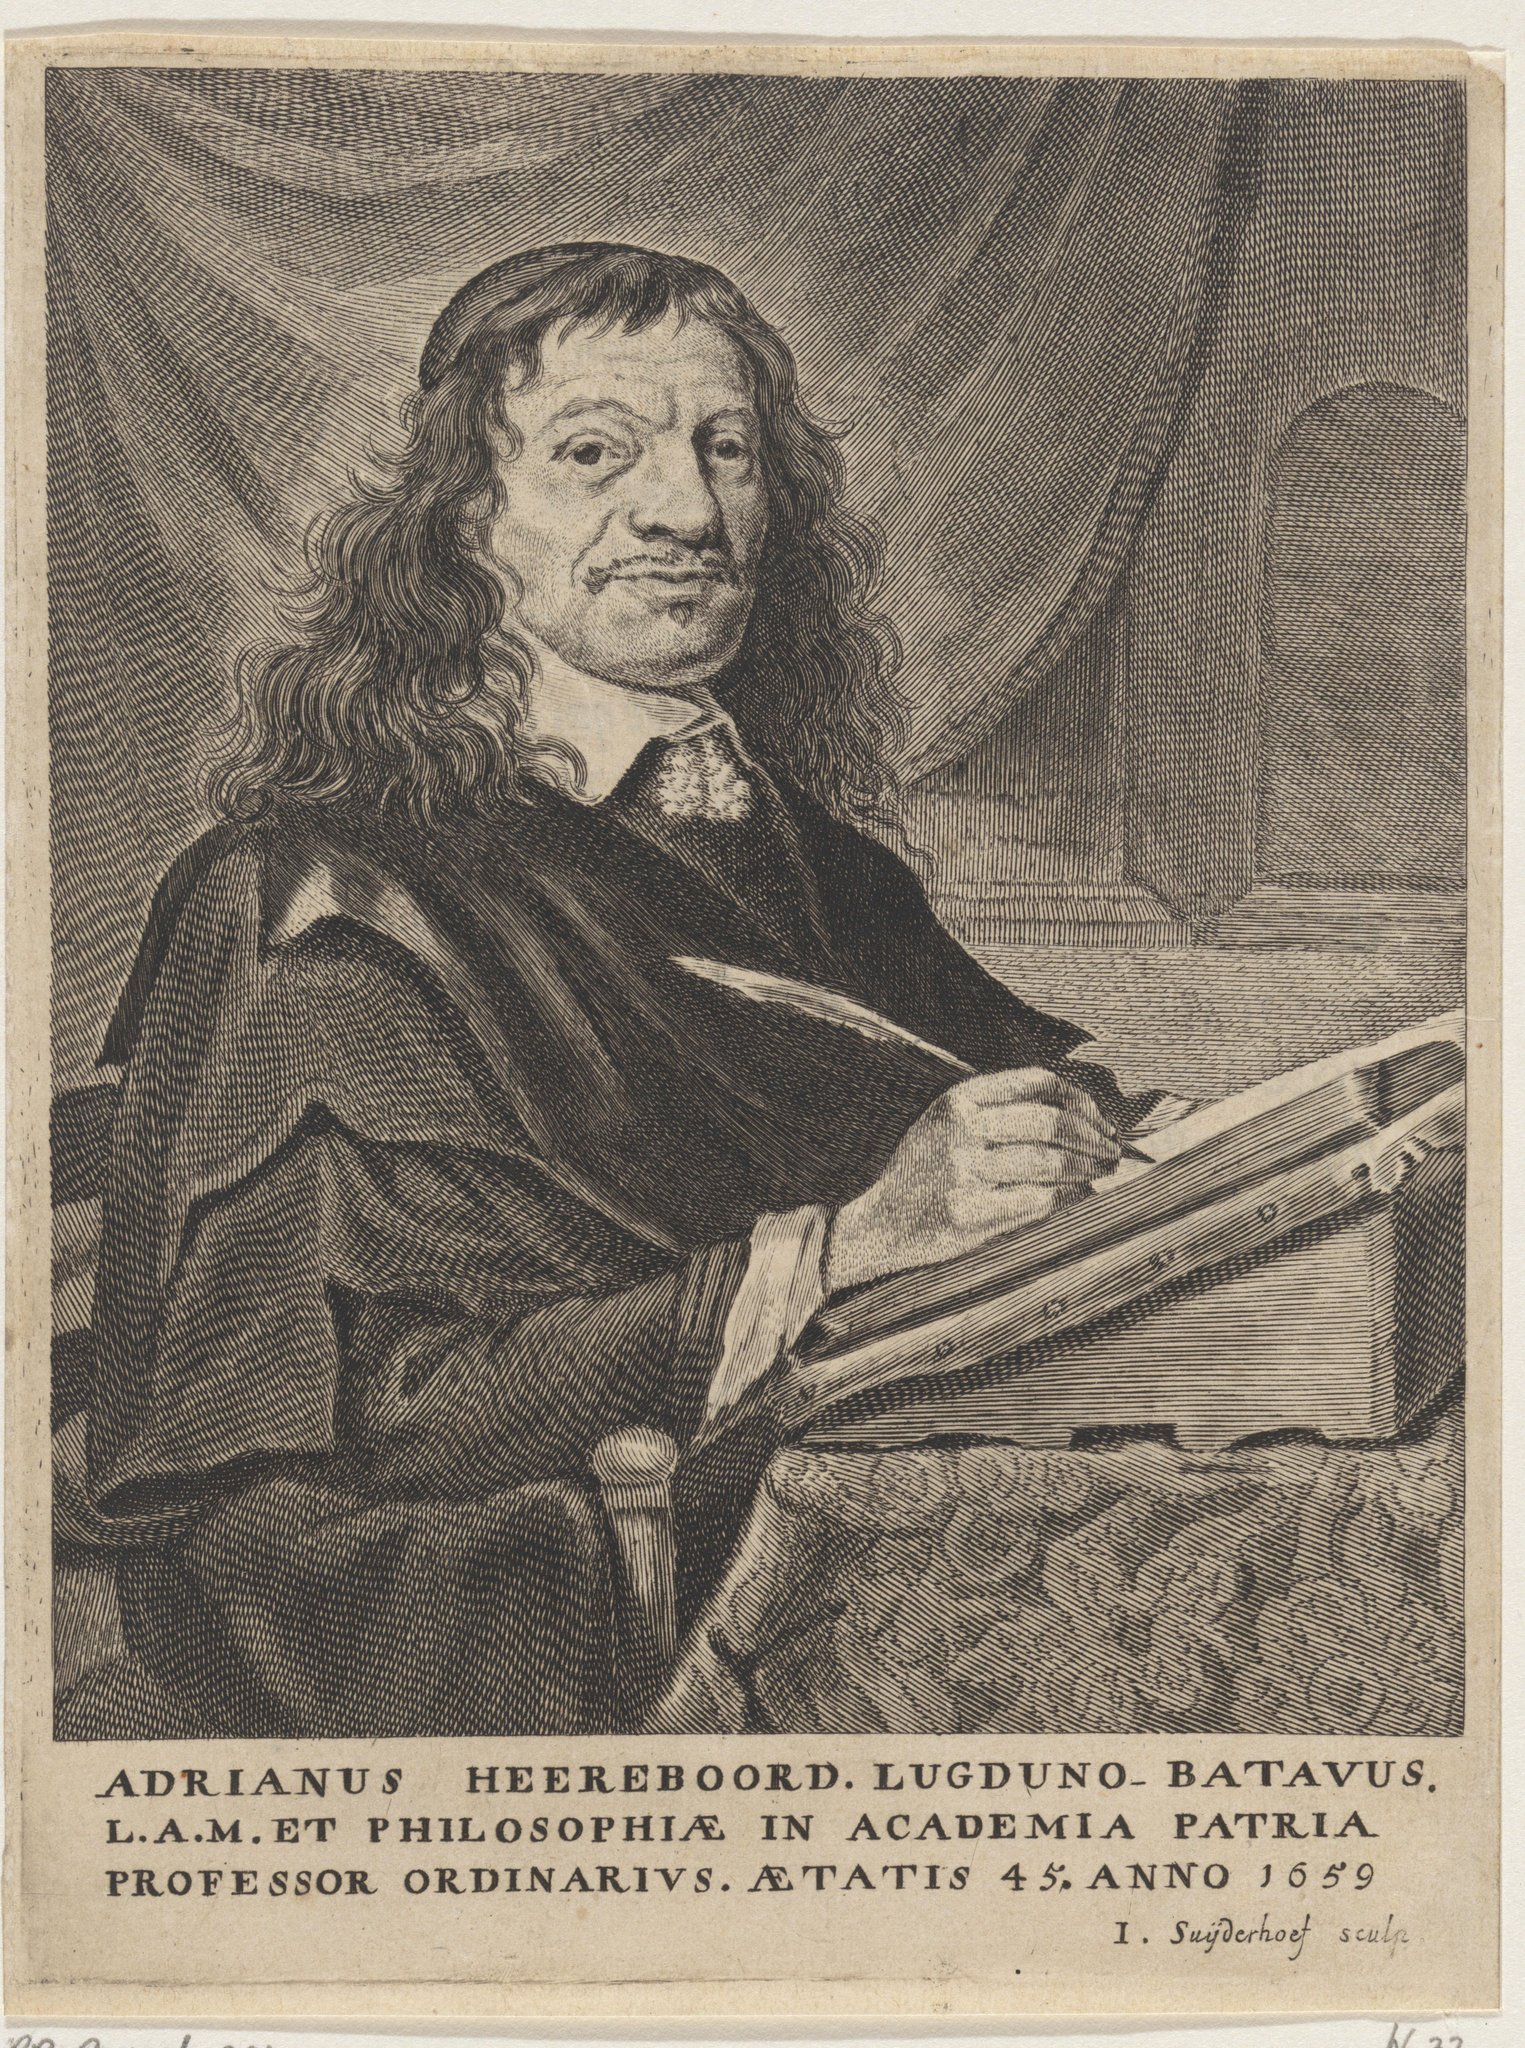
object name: print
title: Portret van Adriaan Heereboord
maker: jonas suyderhoef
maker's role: draughtsman, print maker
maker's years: 1613-1686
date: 1659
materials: paper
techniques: engraving, letterpress printing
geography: haarlem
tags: leiden, scholar in his study, professor (+ portrait of teacher, professor)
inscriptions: collector's mark: Lugt 2228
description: Portret van Adriaan Heereboord, hoogleraar redeneerkunde en wijsbegeerte aan de universiteit van Leiden, met een schrijfveer in de hand zittend aan een lessenaar. Onderaan in de marge een drieregelige tekst in het Latijn.